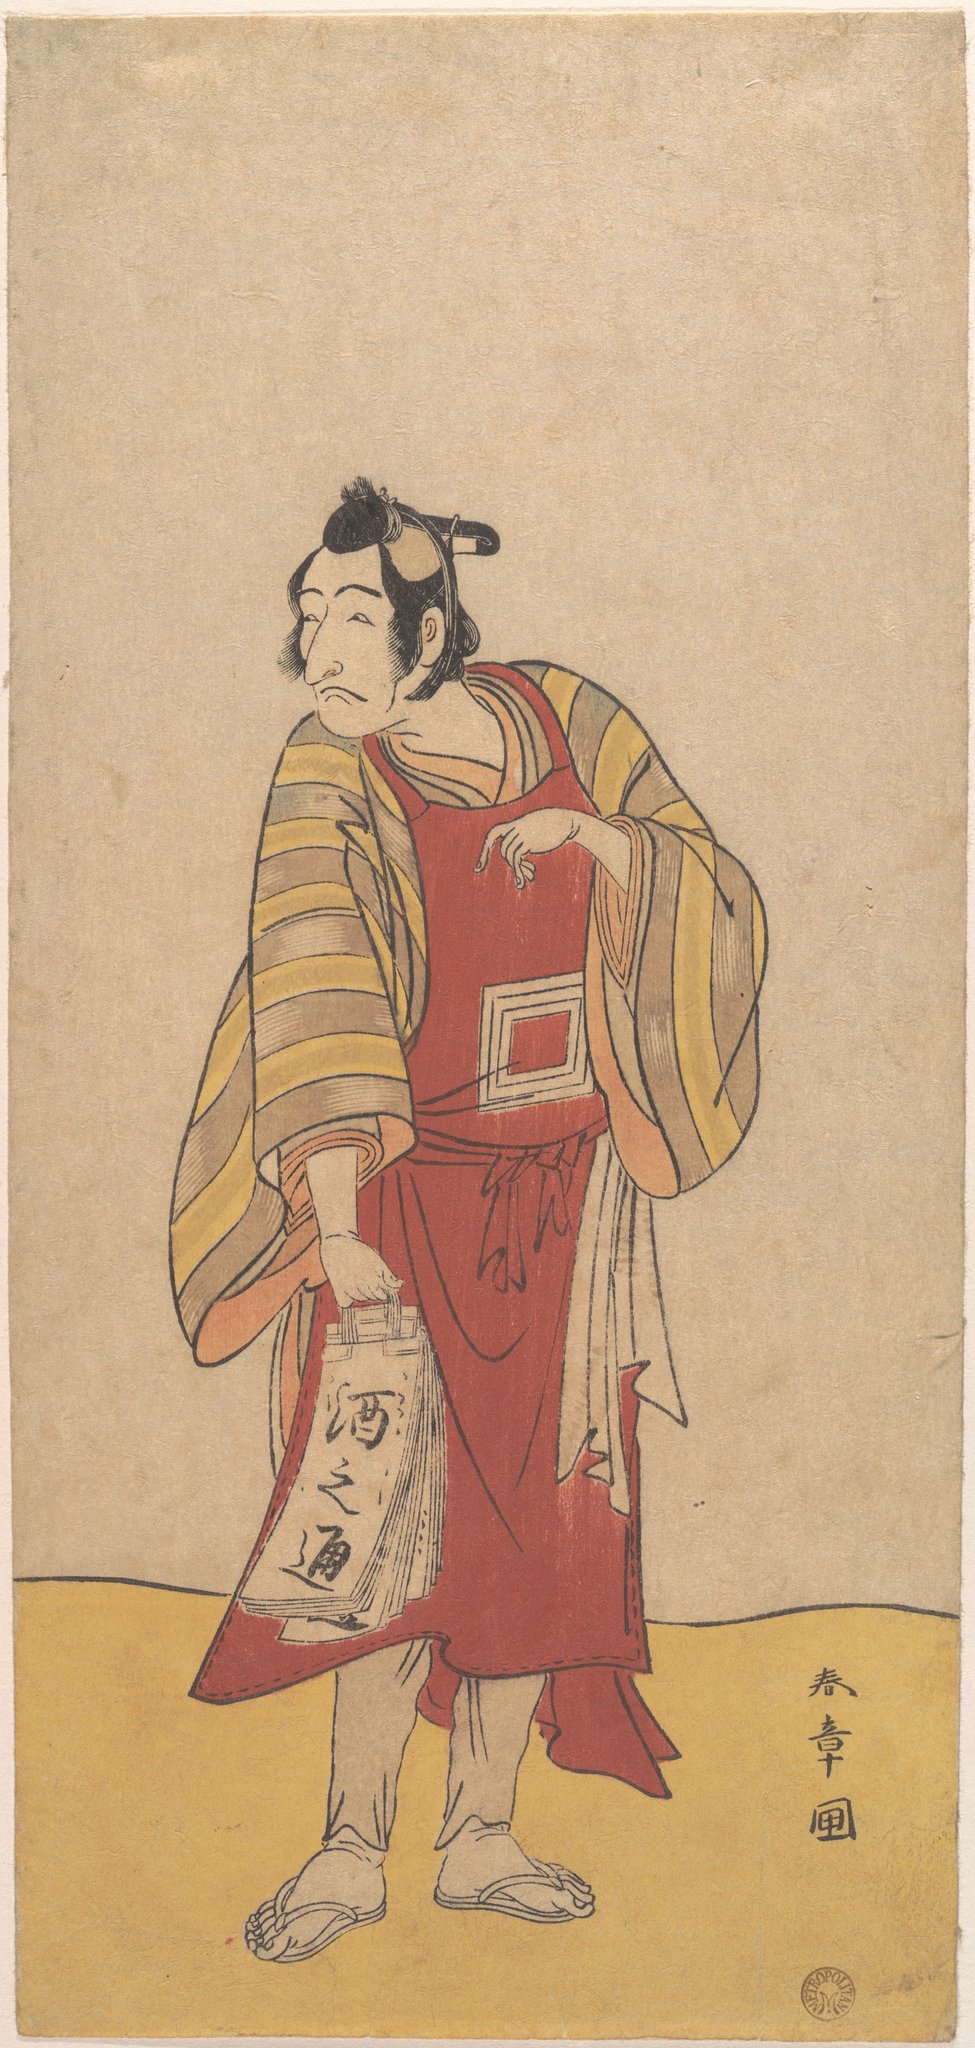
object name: woodblock print nishiki e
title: The Fifth Ichikawa Danjuro as a Man Standing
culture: japanese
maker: katsukawa shunshō 勝川春章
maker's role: artist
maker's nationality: japanese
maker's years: 1726-1792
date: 1775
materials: ink, paper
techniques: nishiki e, woodblock print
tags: men,actors